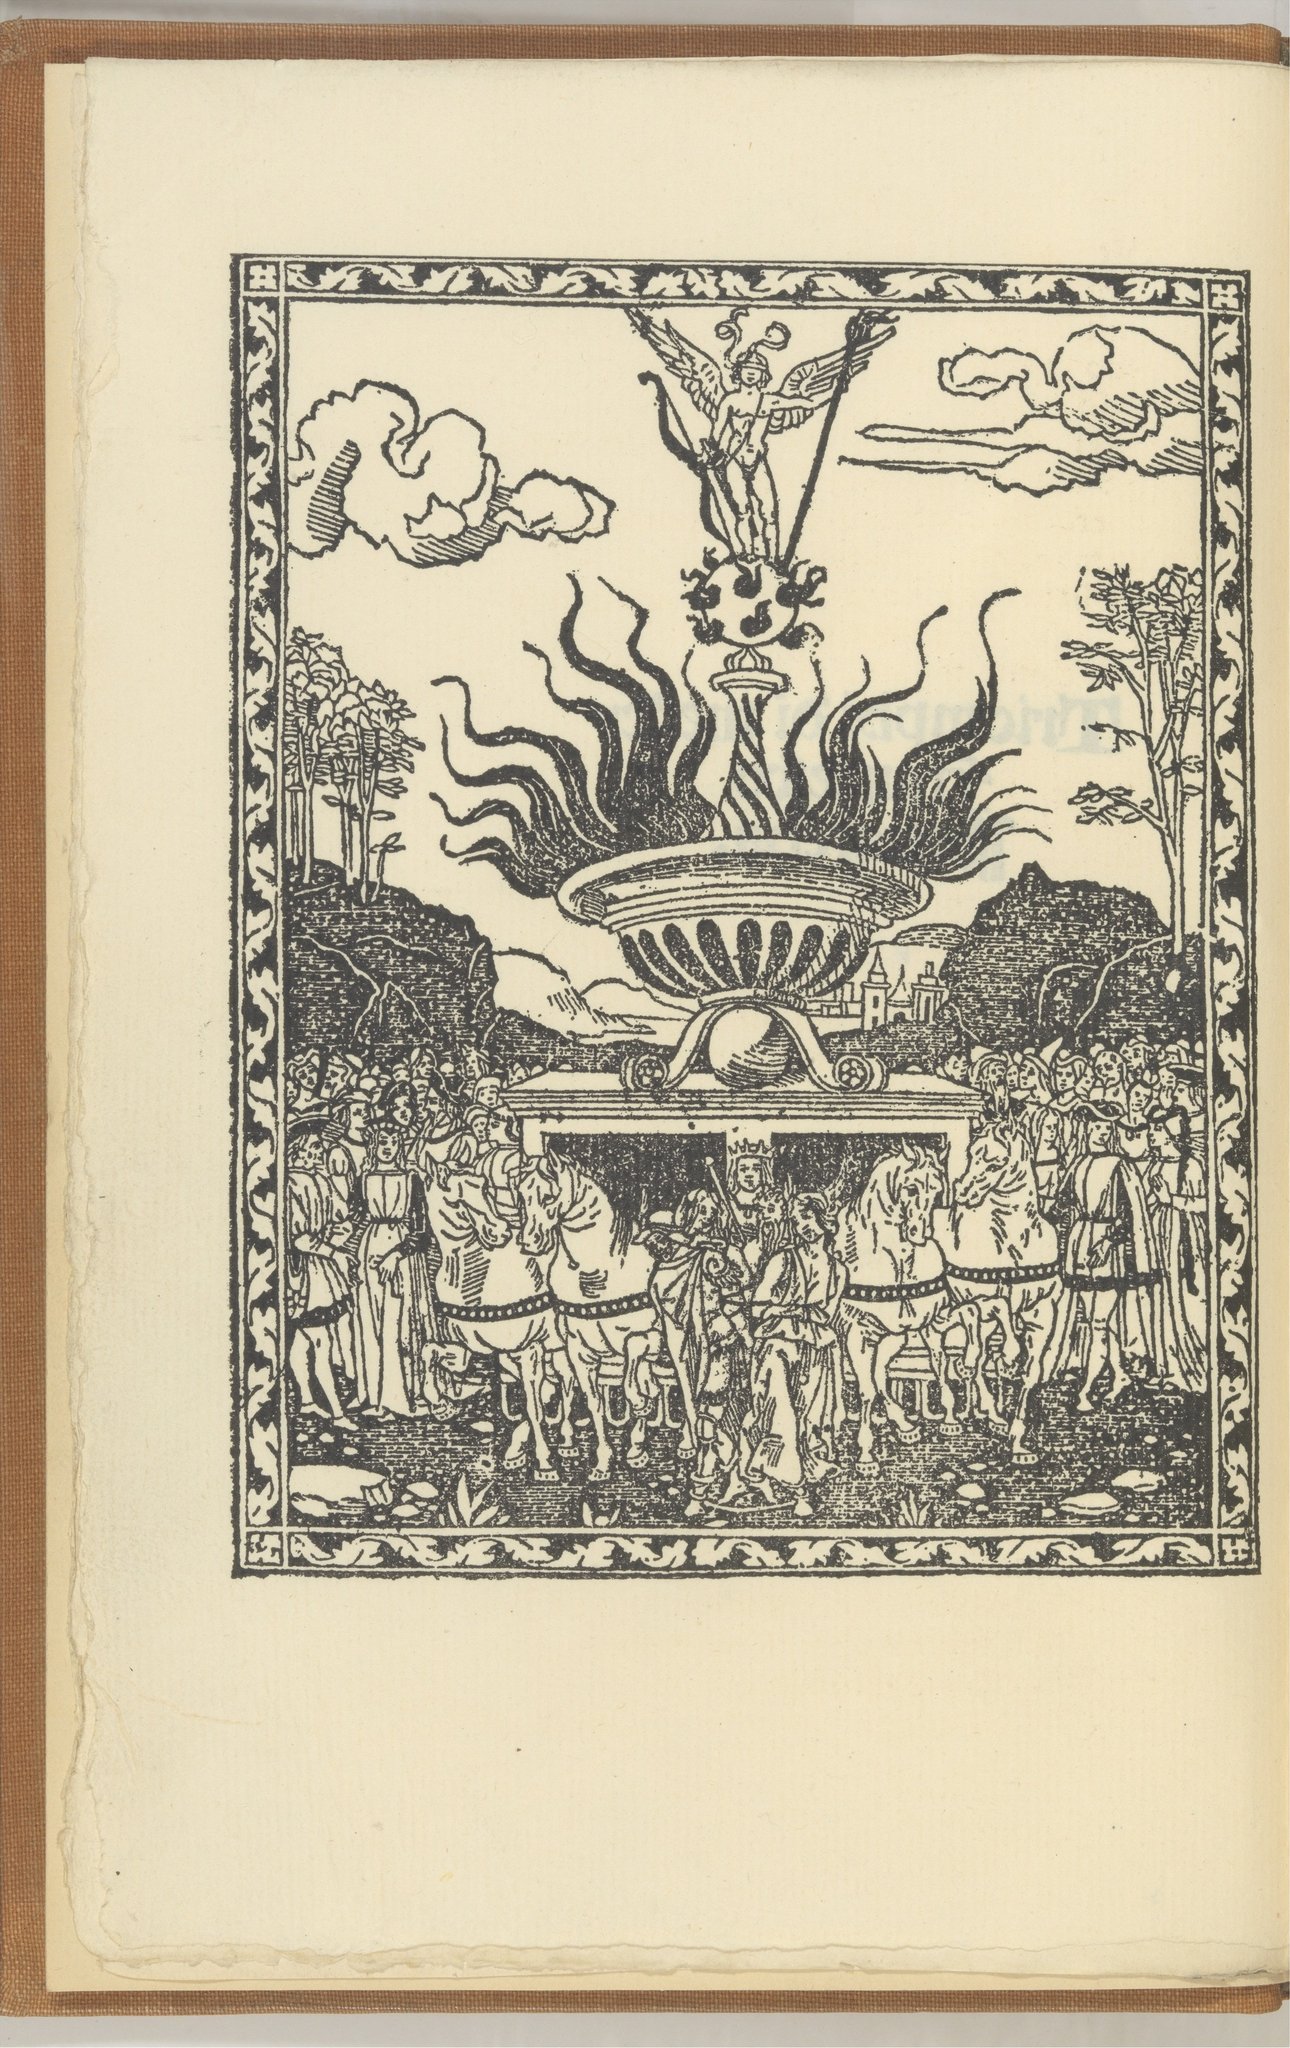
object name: book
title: Triomphi di messer Francesco Petracha (facsimile)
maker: francesco petrarca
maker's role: author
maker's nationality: italian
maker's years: 1304-1374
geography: venice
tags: bow and arrow,horses,angels